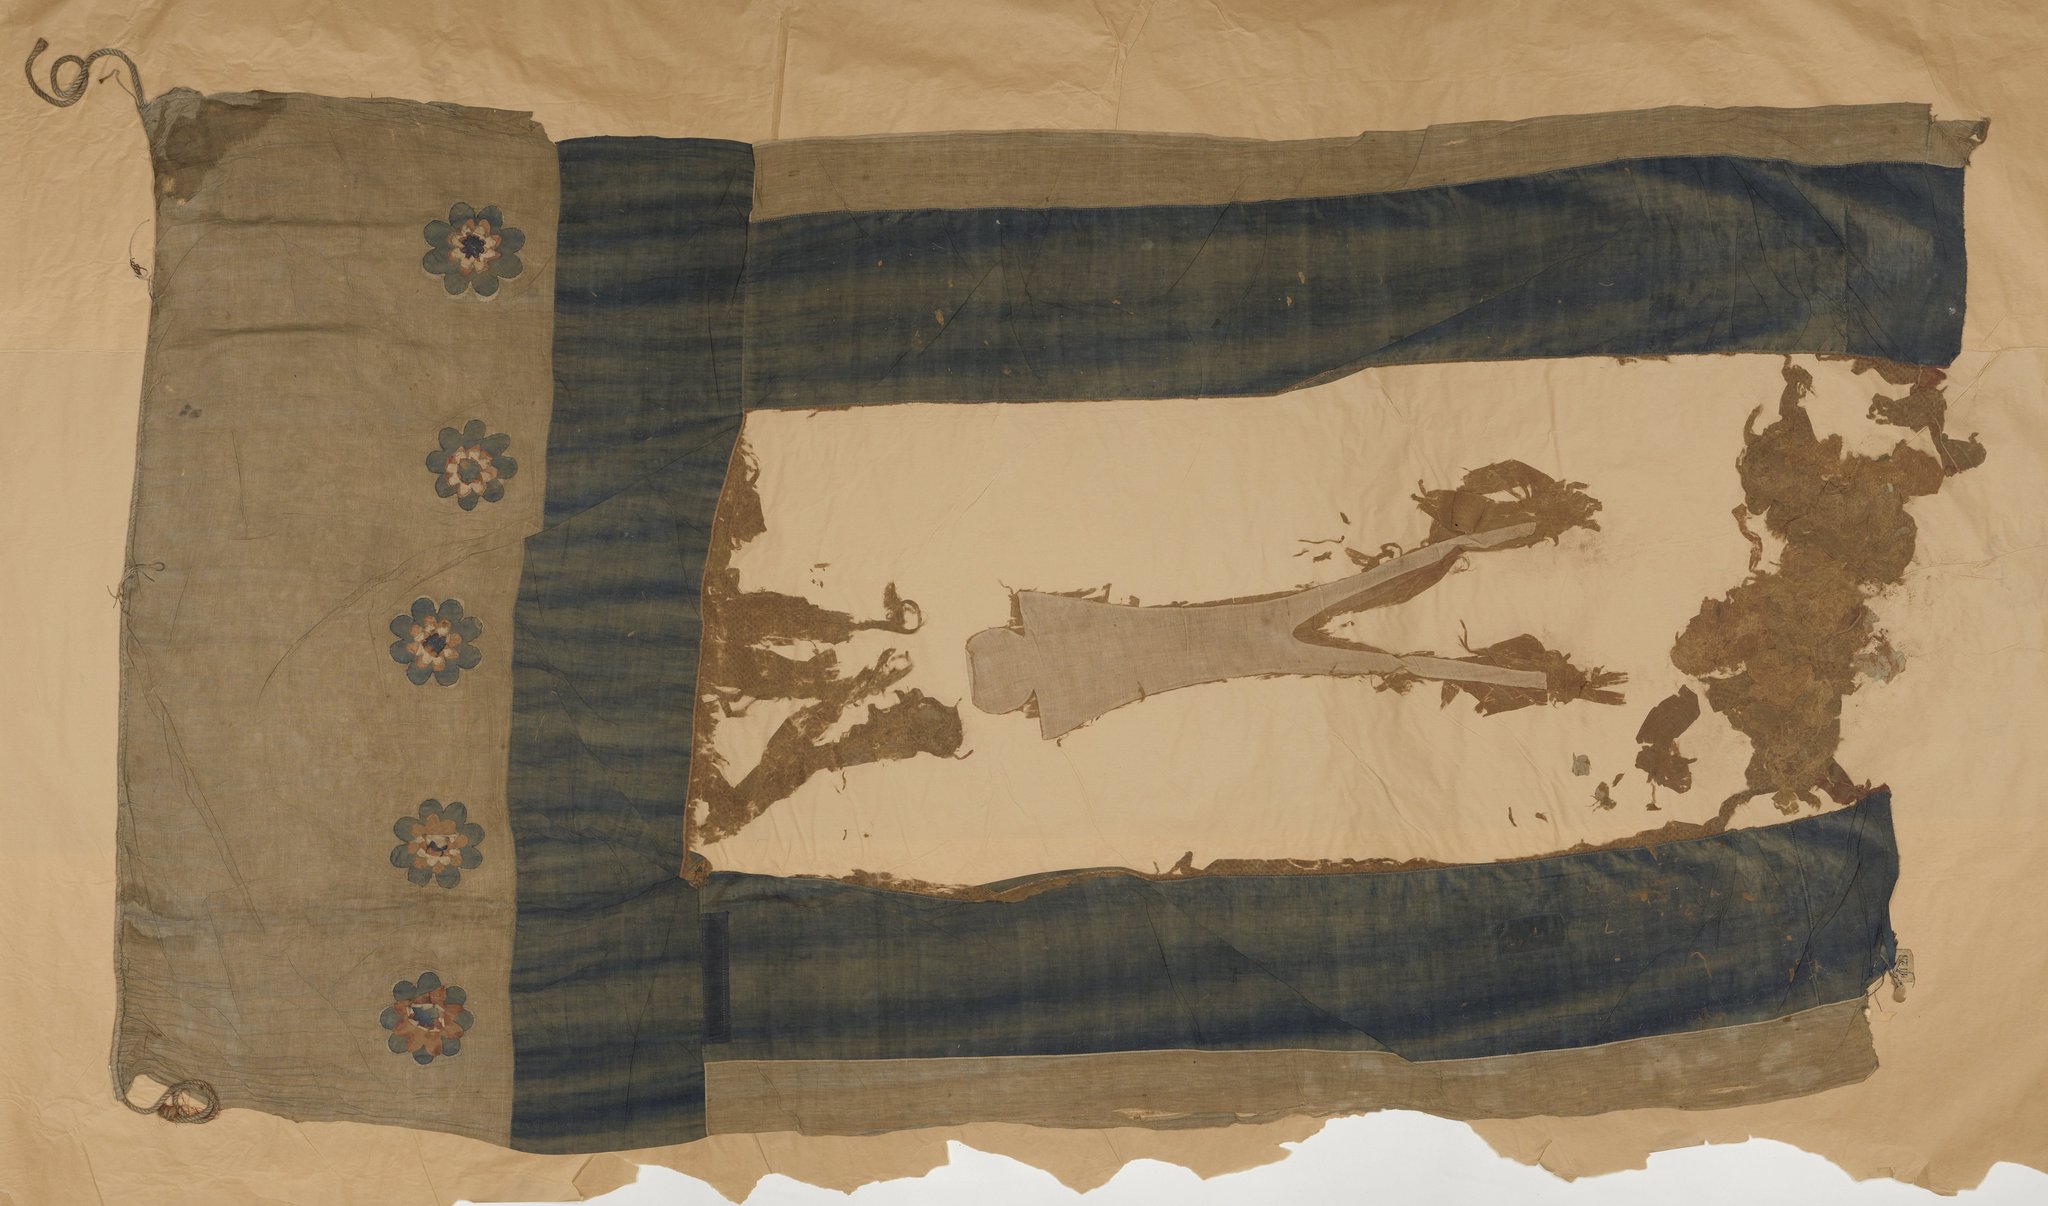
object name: flag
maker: Anonymous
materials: cotton, linen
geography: indonesian archipelago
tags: flag, colours (as symbol of the state, etc.)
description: Deze en de vlaggen NG-MC-1125-B en C werden door het schroefstoomschip Reteh (6 stukken, oorspronkelijk de Sprinkhaan, lang 43 m, gebouwd te Amsterdam in 1858-1860, niet meer vernoemd vanaf 1872) veroverd op piraten die zich verschanst hadden op een eilandje in de baai van Lobo. Het eiland is Jolly-eiland genoemd, naar Ltz. H.L. Jolly die bij deze actie het leven verloor.